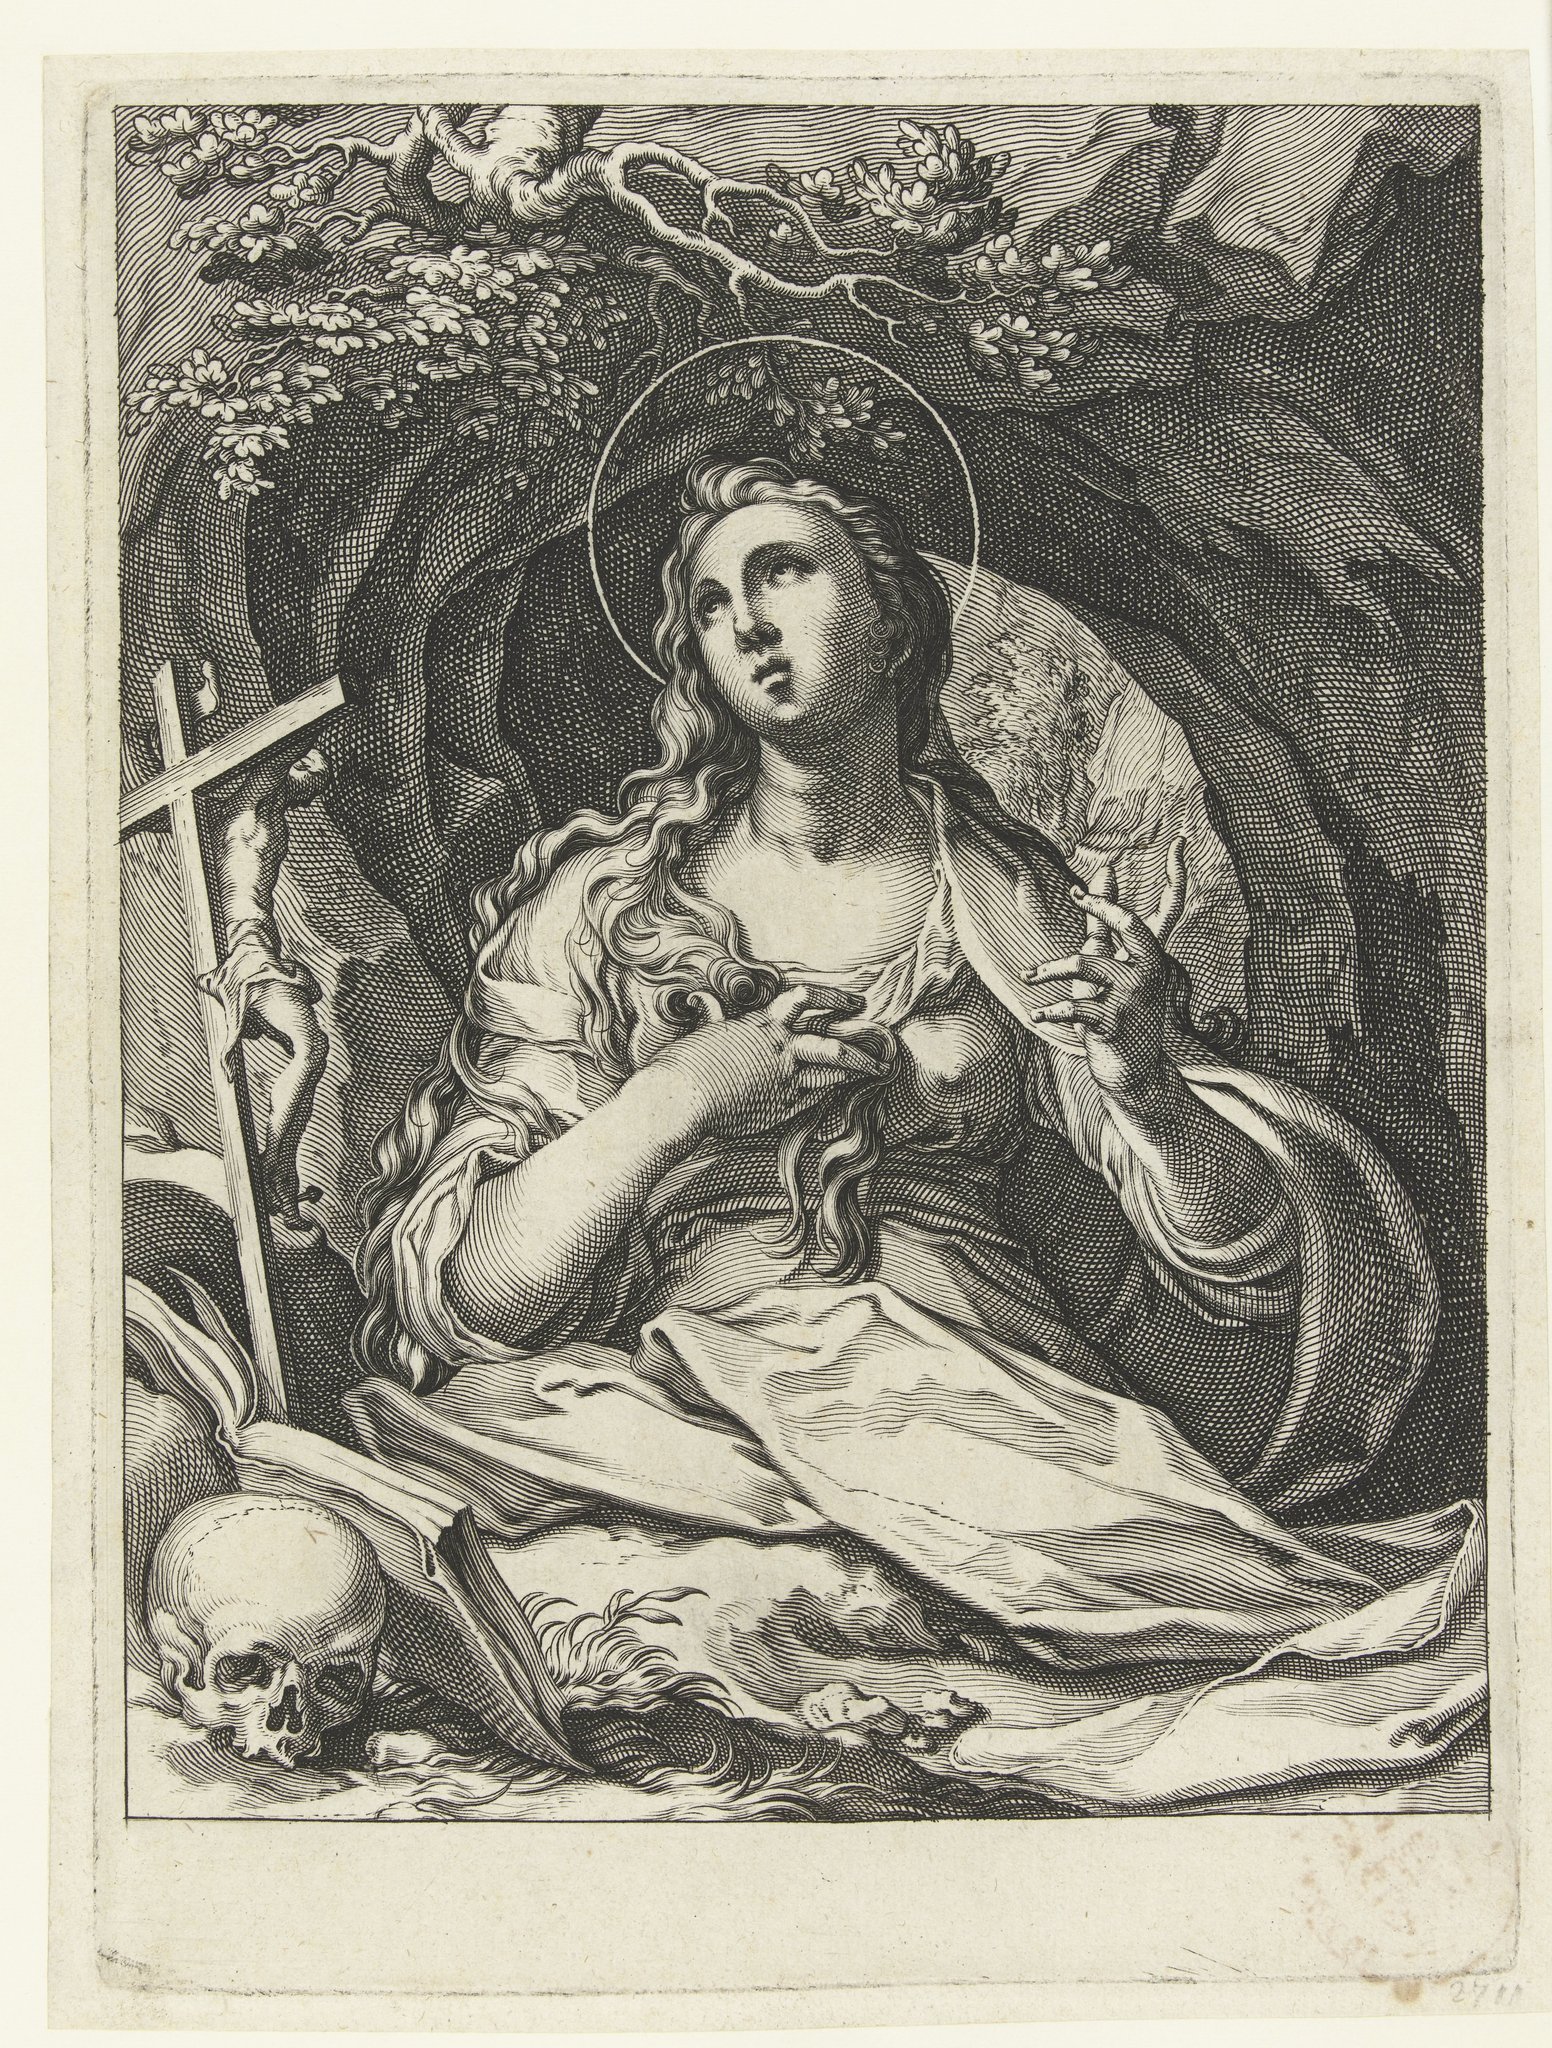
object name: print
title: Maria Magdalena in een grot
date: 1593-1597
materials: paper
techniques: engraving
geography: netherlands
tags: the penitent harlot mary magdalene; possible attributes: book (or scroll), crown, crown of thorns, crucifix, jar of ointment, mirror, musical instrument, palm-branch, rosary, scourge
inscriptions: collector's mark: Lugt 240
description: Maria Magdalena in een grot, ten halven lijve, voor een crucifix, een boek en een schedel. Onder de voorstelling is ruimte leeg gelaten voor een onderschrift.